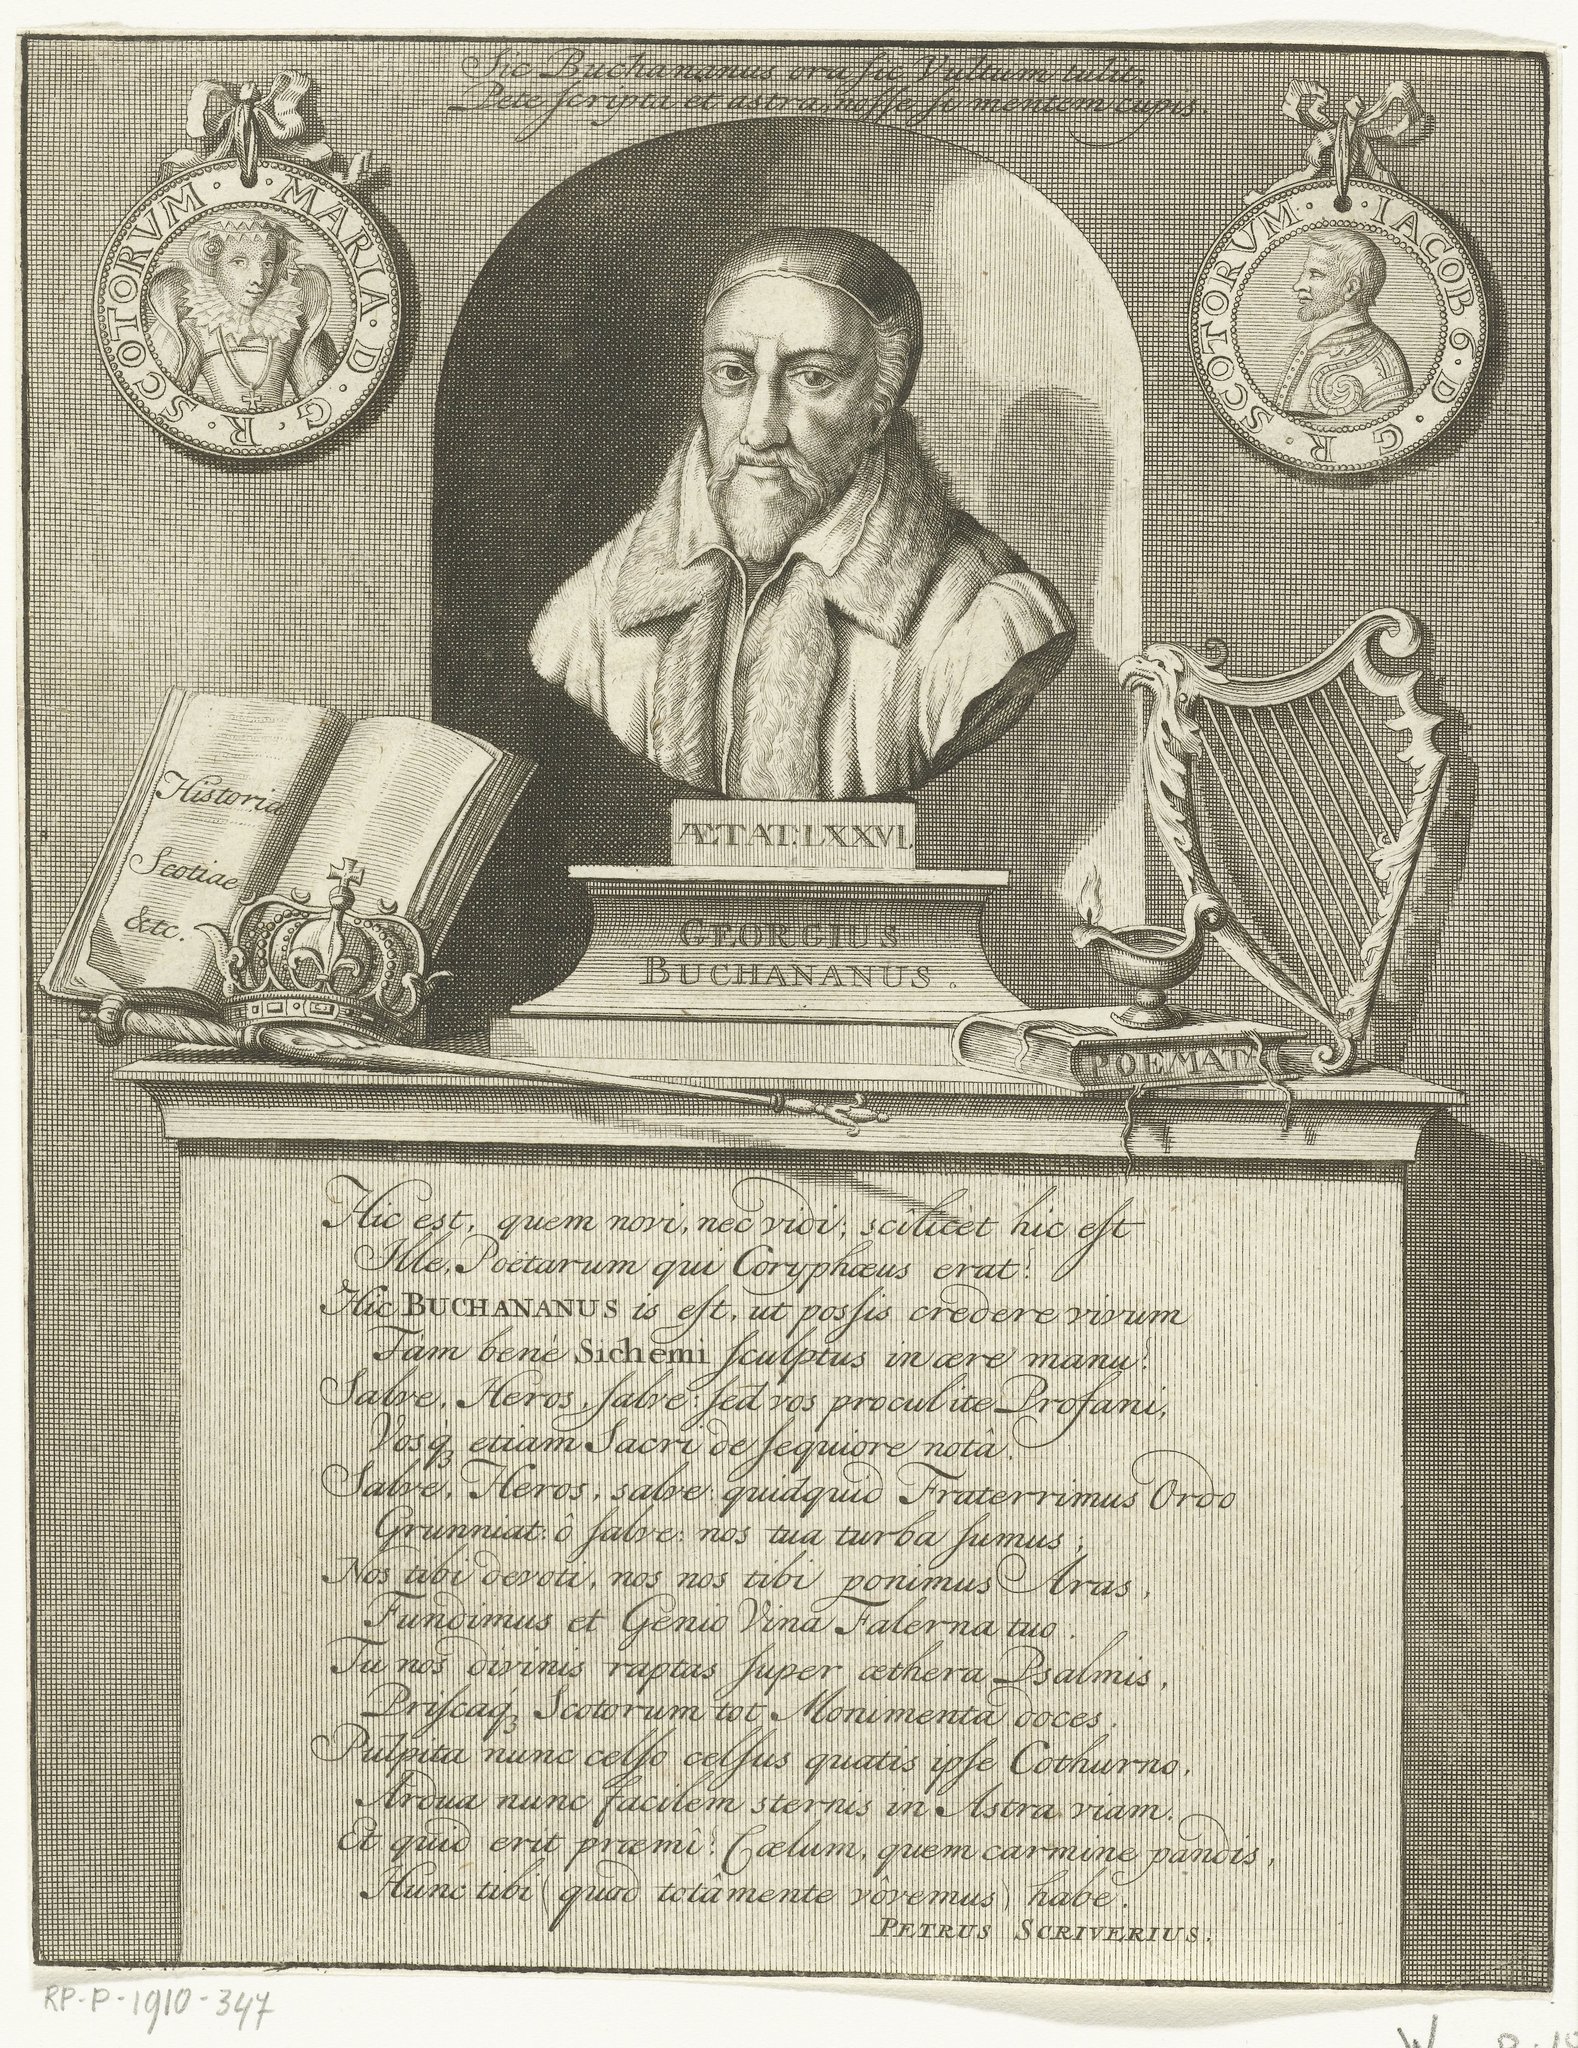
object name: print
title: Georgius Buchananus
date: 1673-1744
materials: paper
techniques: etching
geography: netherlands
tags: george buchanan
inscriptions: collector's mark: Lugt 2228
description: Buste van historicus George Buchanan op een sokkel die staat voor een kleine nis op een console. Daar bovenop staan verschillende voorwerpen bij de buste: scepter, kroon, harp, boeken en een olielamp. Een Latijns vers eert de man.